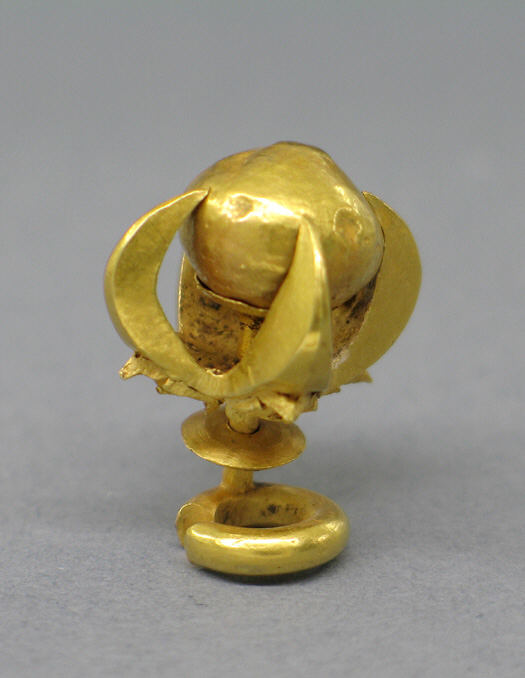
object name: ear clip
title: Ear Clip with Gold Bead set in Four Prong Mount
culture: indonesian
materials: gold